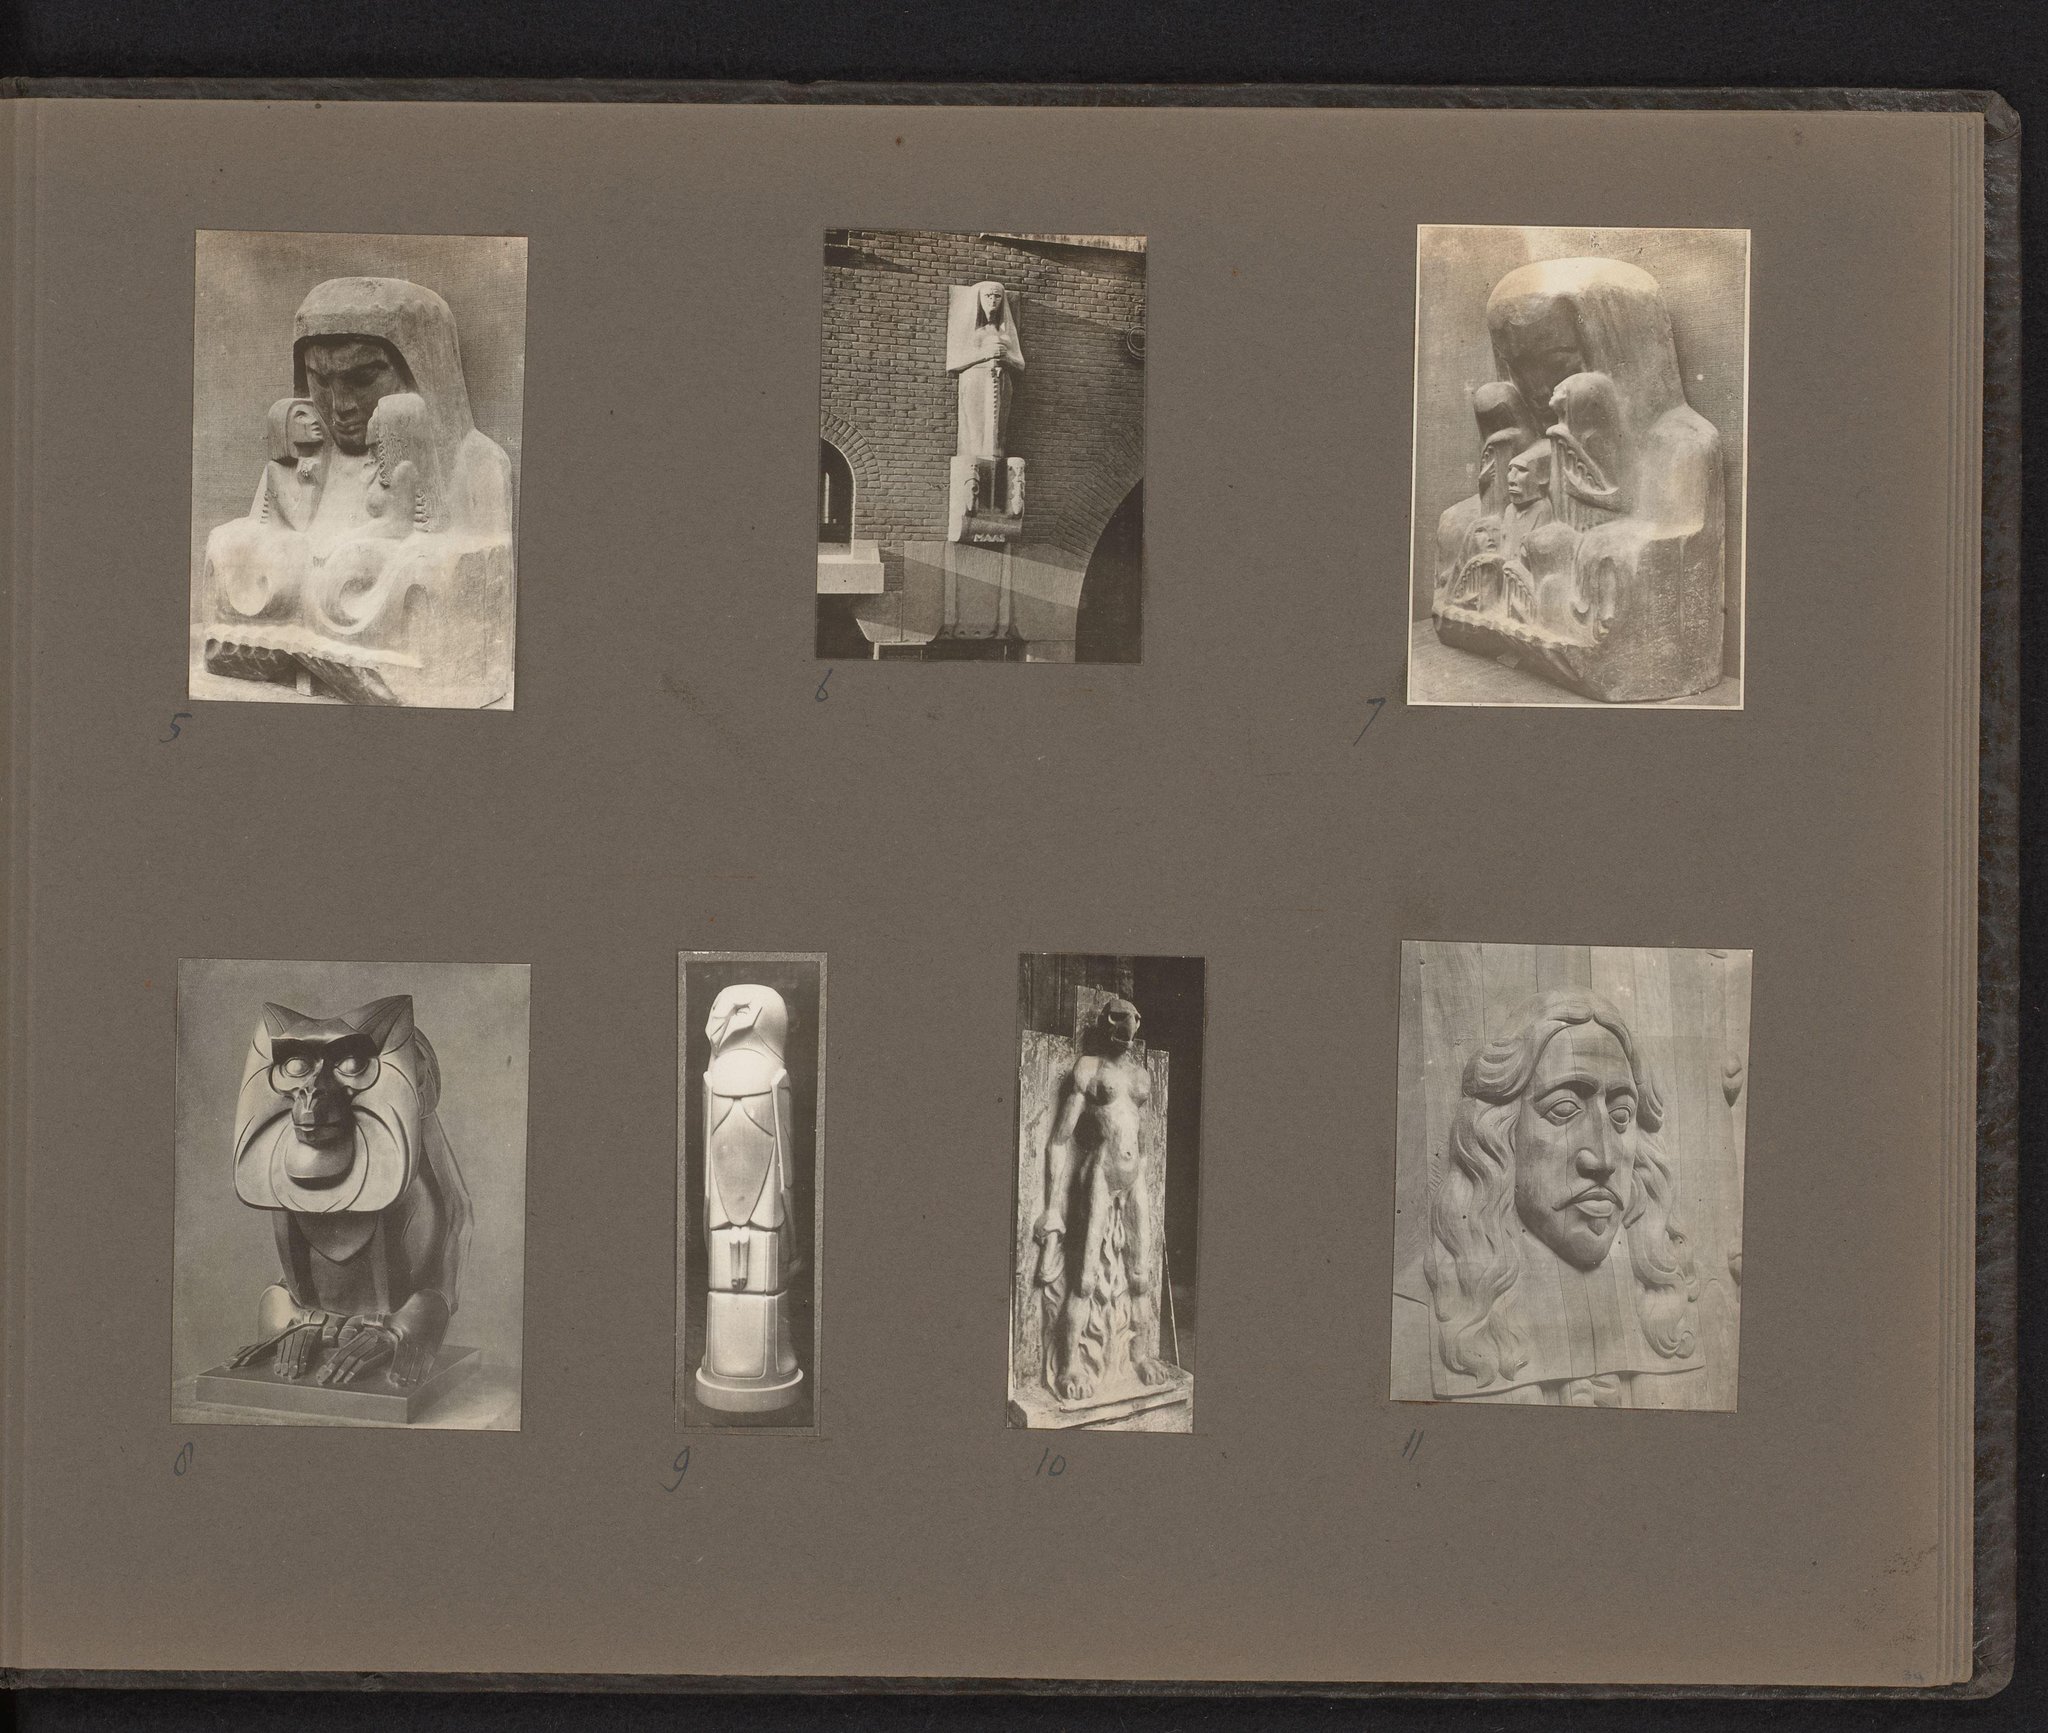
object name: album leaf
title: Zes sculpturen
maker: Anonymous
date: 1920-1940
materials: paper, photographic support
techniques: gelatin silver print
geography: netherlands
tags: monkeys, apes, birds, adult man, piece of sculpture, reproduction of a piece of sculpture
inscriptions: number: ‘5 - 6 - 7/ 8 - 9 - 10 - 11’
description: Afgebeeld zijn vier sculpturen van één of meerdere personen, een aap, een vogel en een staande vrouw met vogelmasker. Deze foto's maken deel uit van een album.